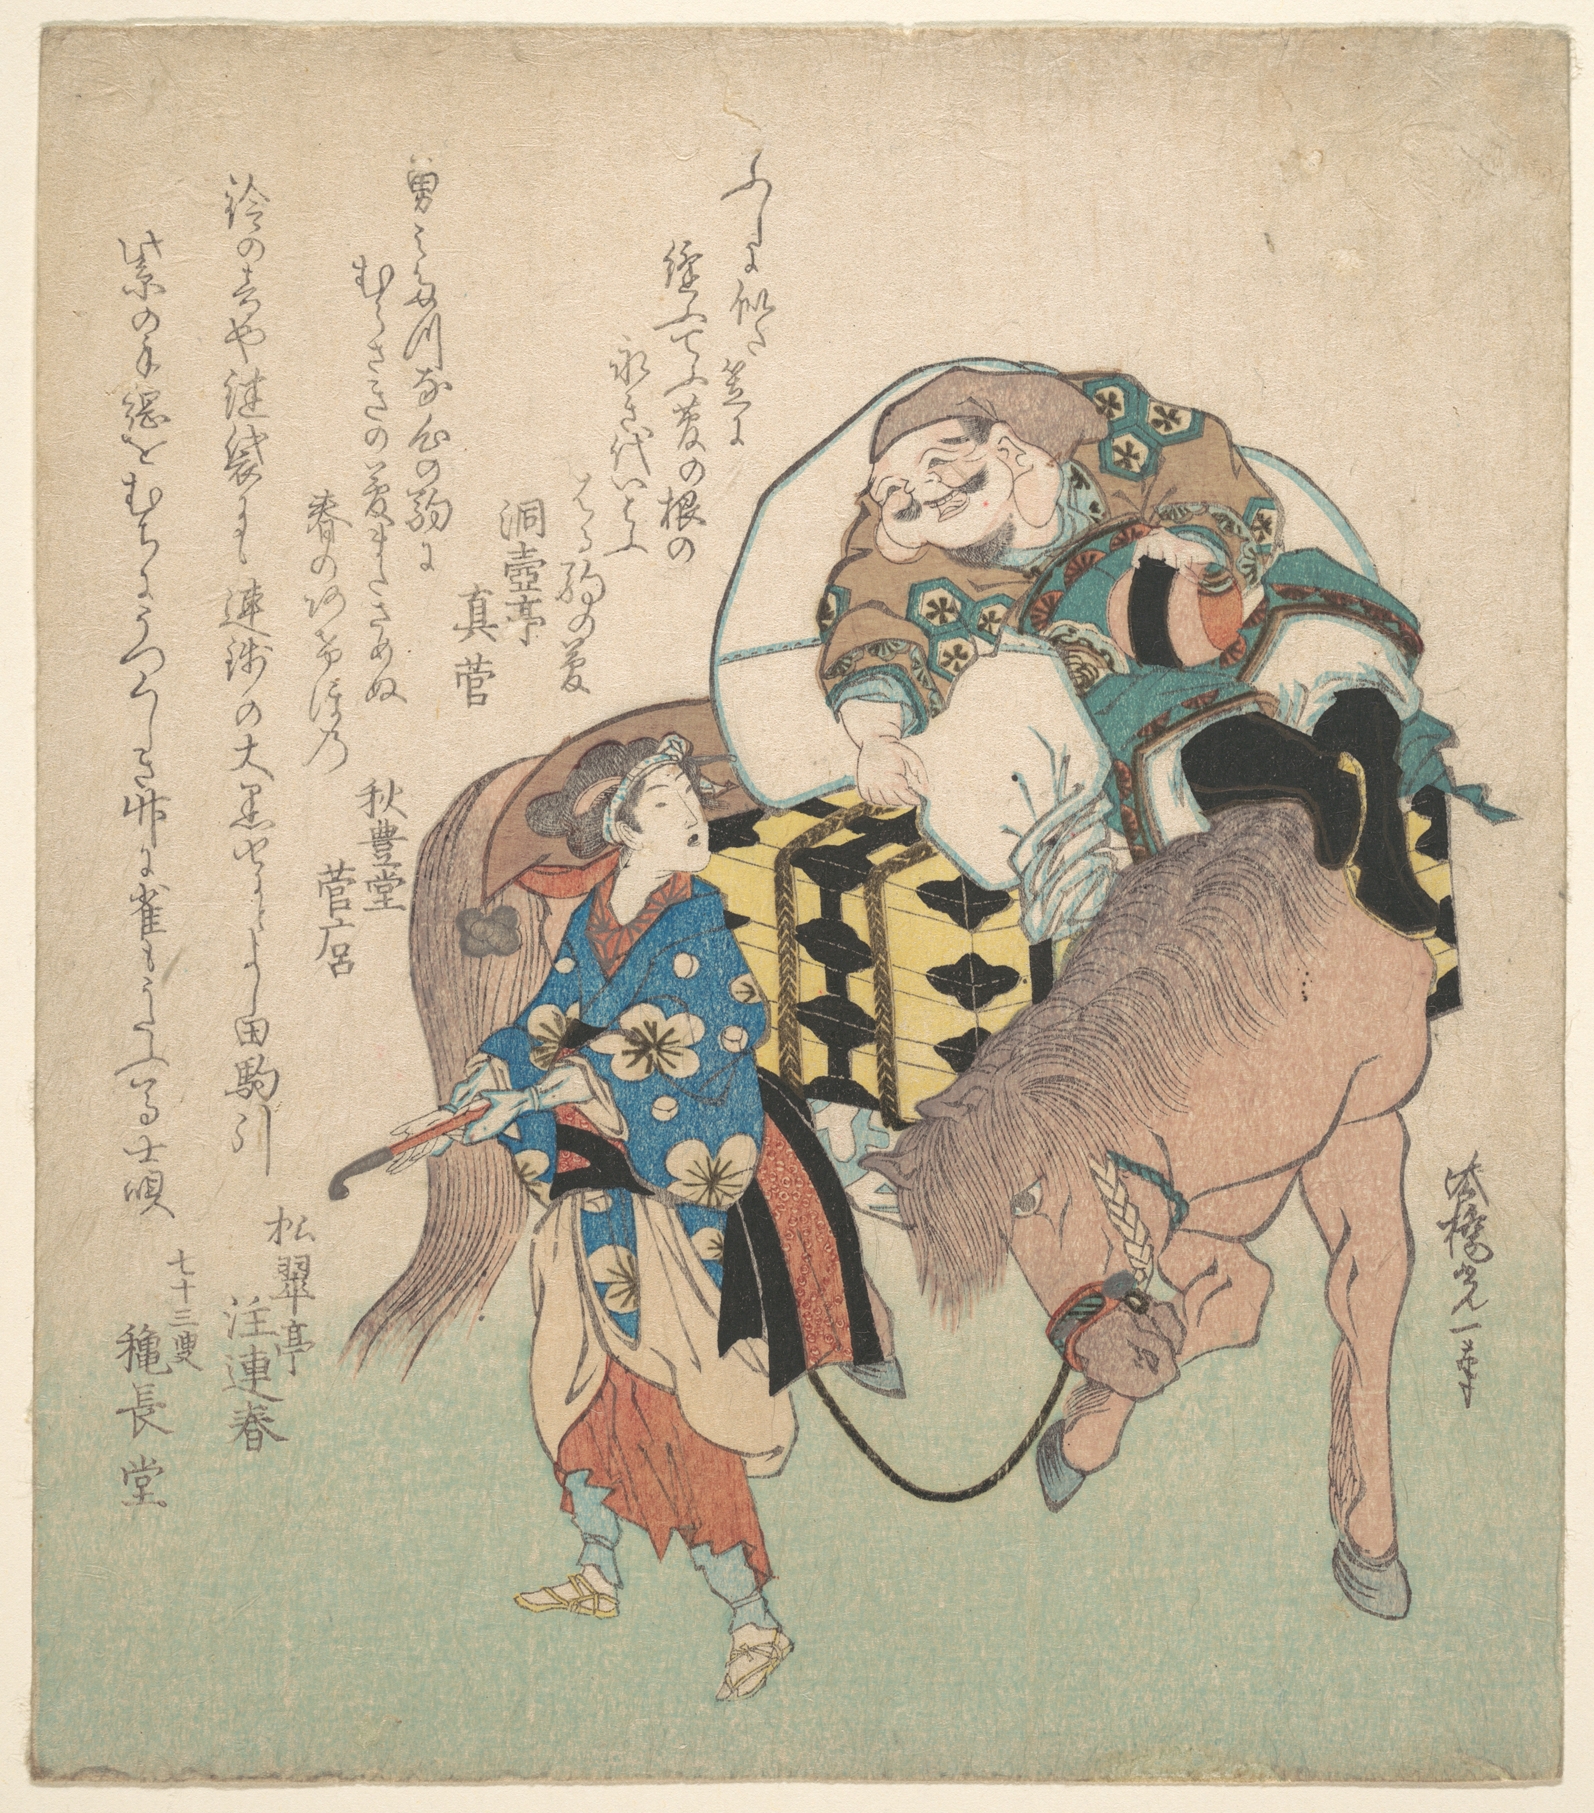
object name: woodblock print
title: The God of Good Fortune Daikoku, on Horseback, Being Led by an Ohara Maiden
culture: japanese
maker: hokkyō kōitsu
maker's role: artist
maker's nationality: japanese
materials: ink, paper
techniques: surimono, woodblock print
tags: girls,men,horses